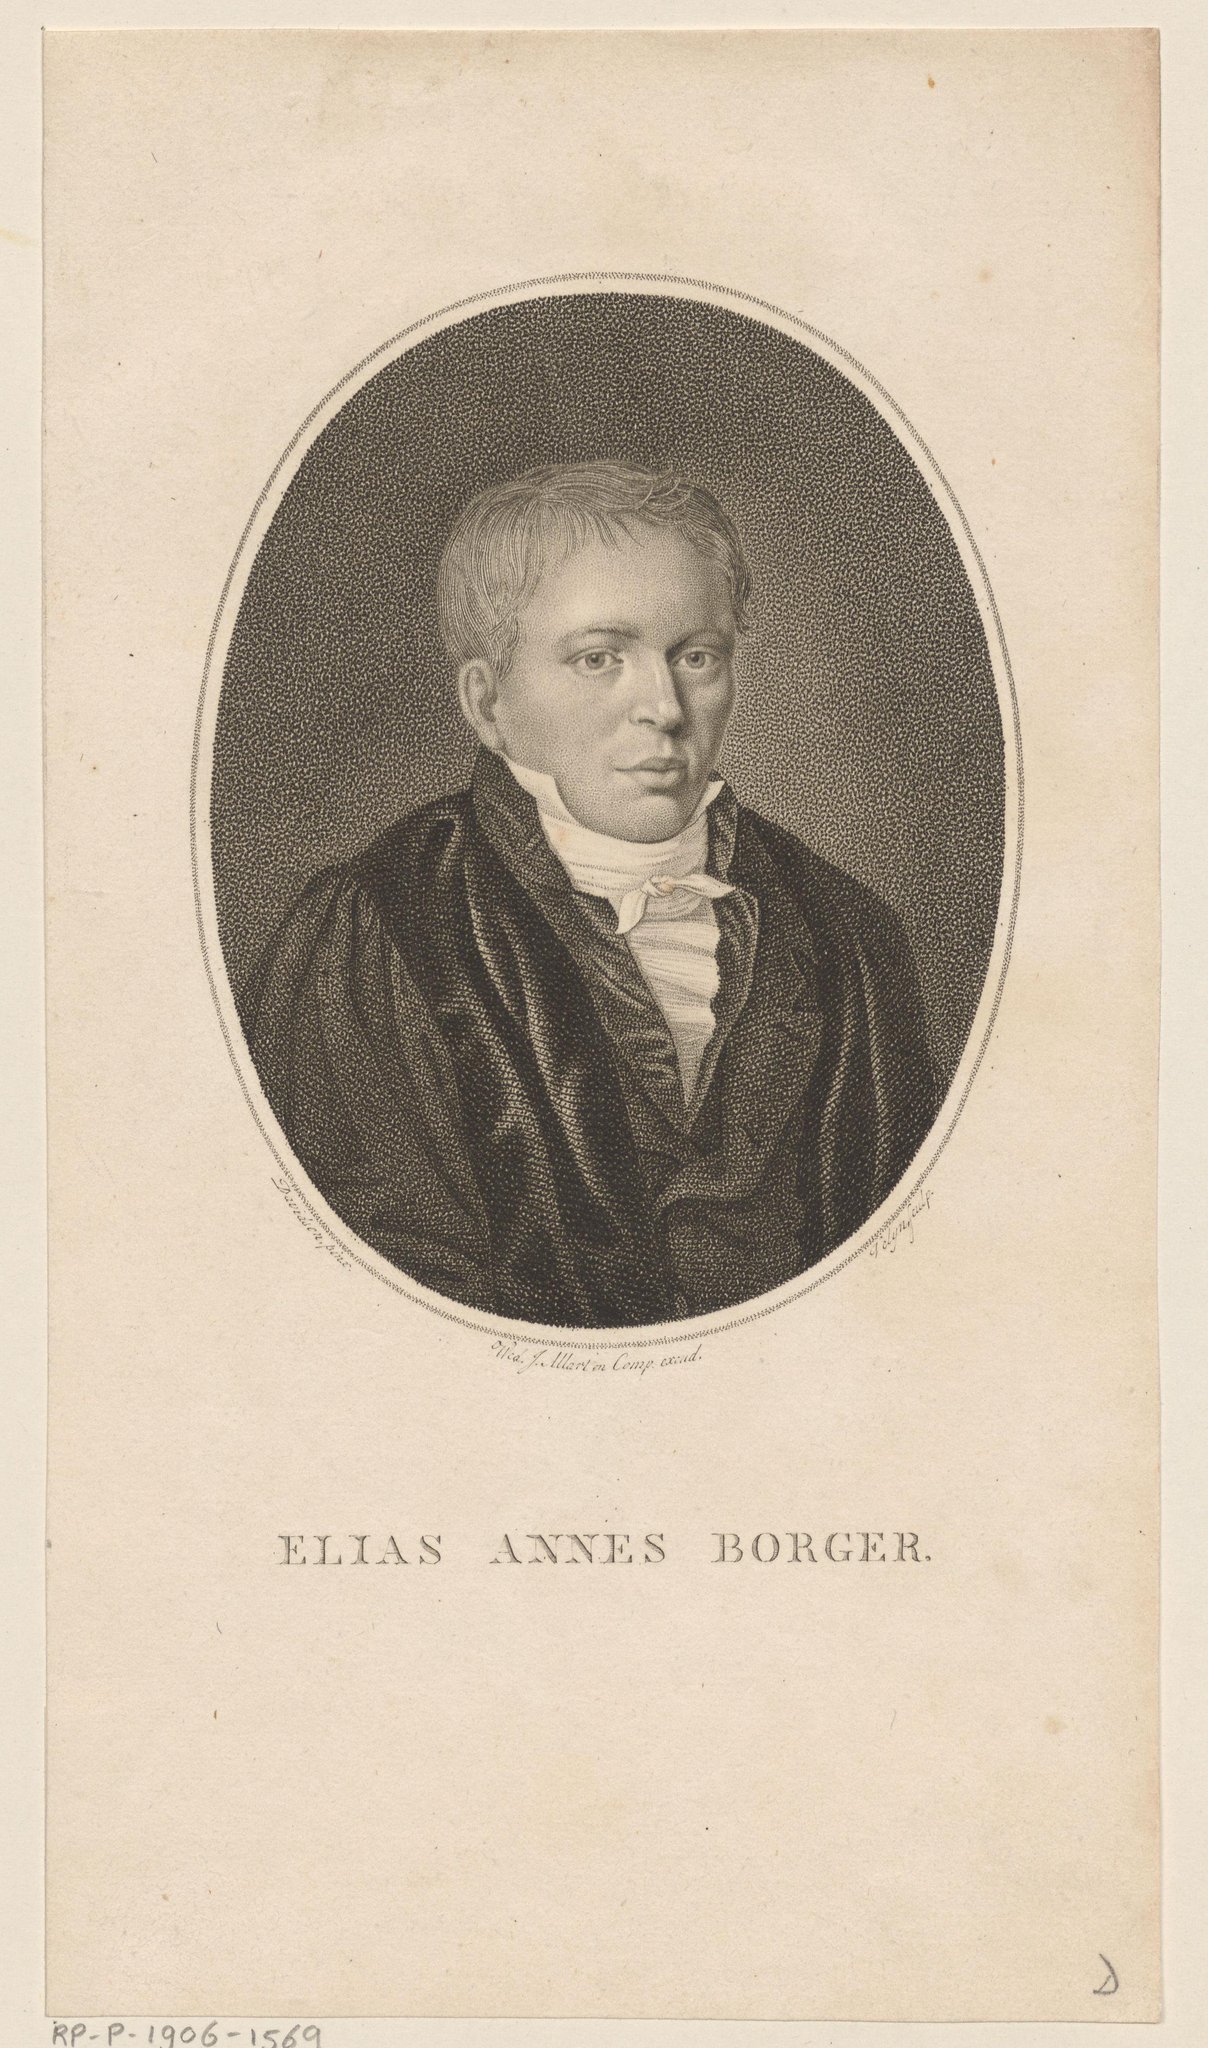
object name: print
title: Portret van Elias Anne Borger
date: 1820-1822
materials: paper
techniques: etching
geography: amsterdam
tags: scholar, philosopher, historical persons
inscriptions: collector's mark: Lugt 2228